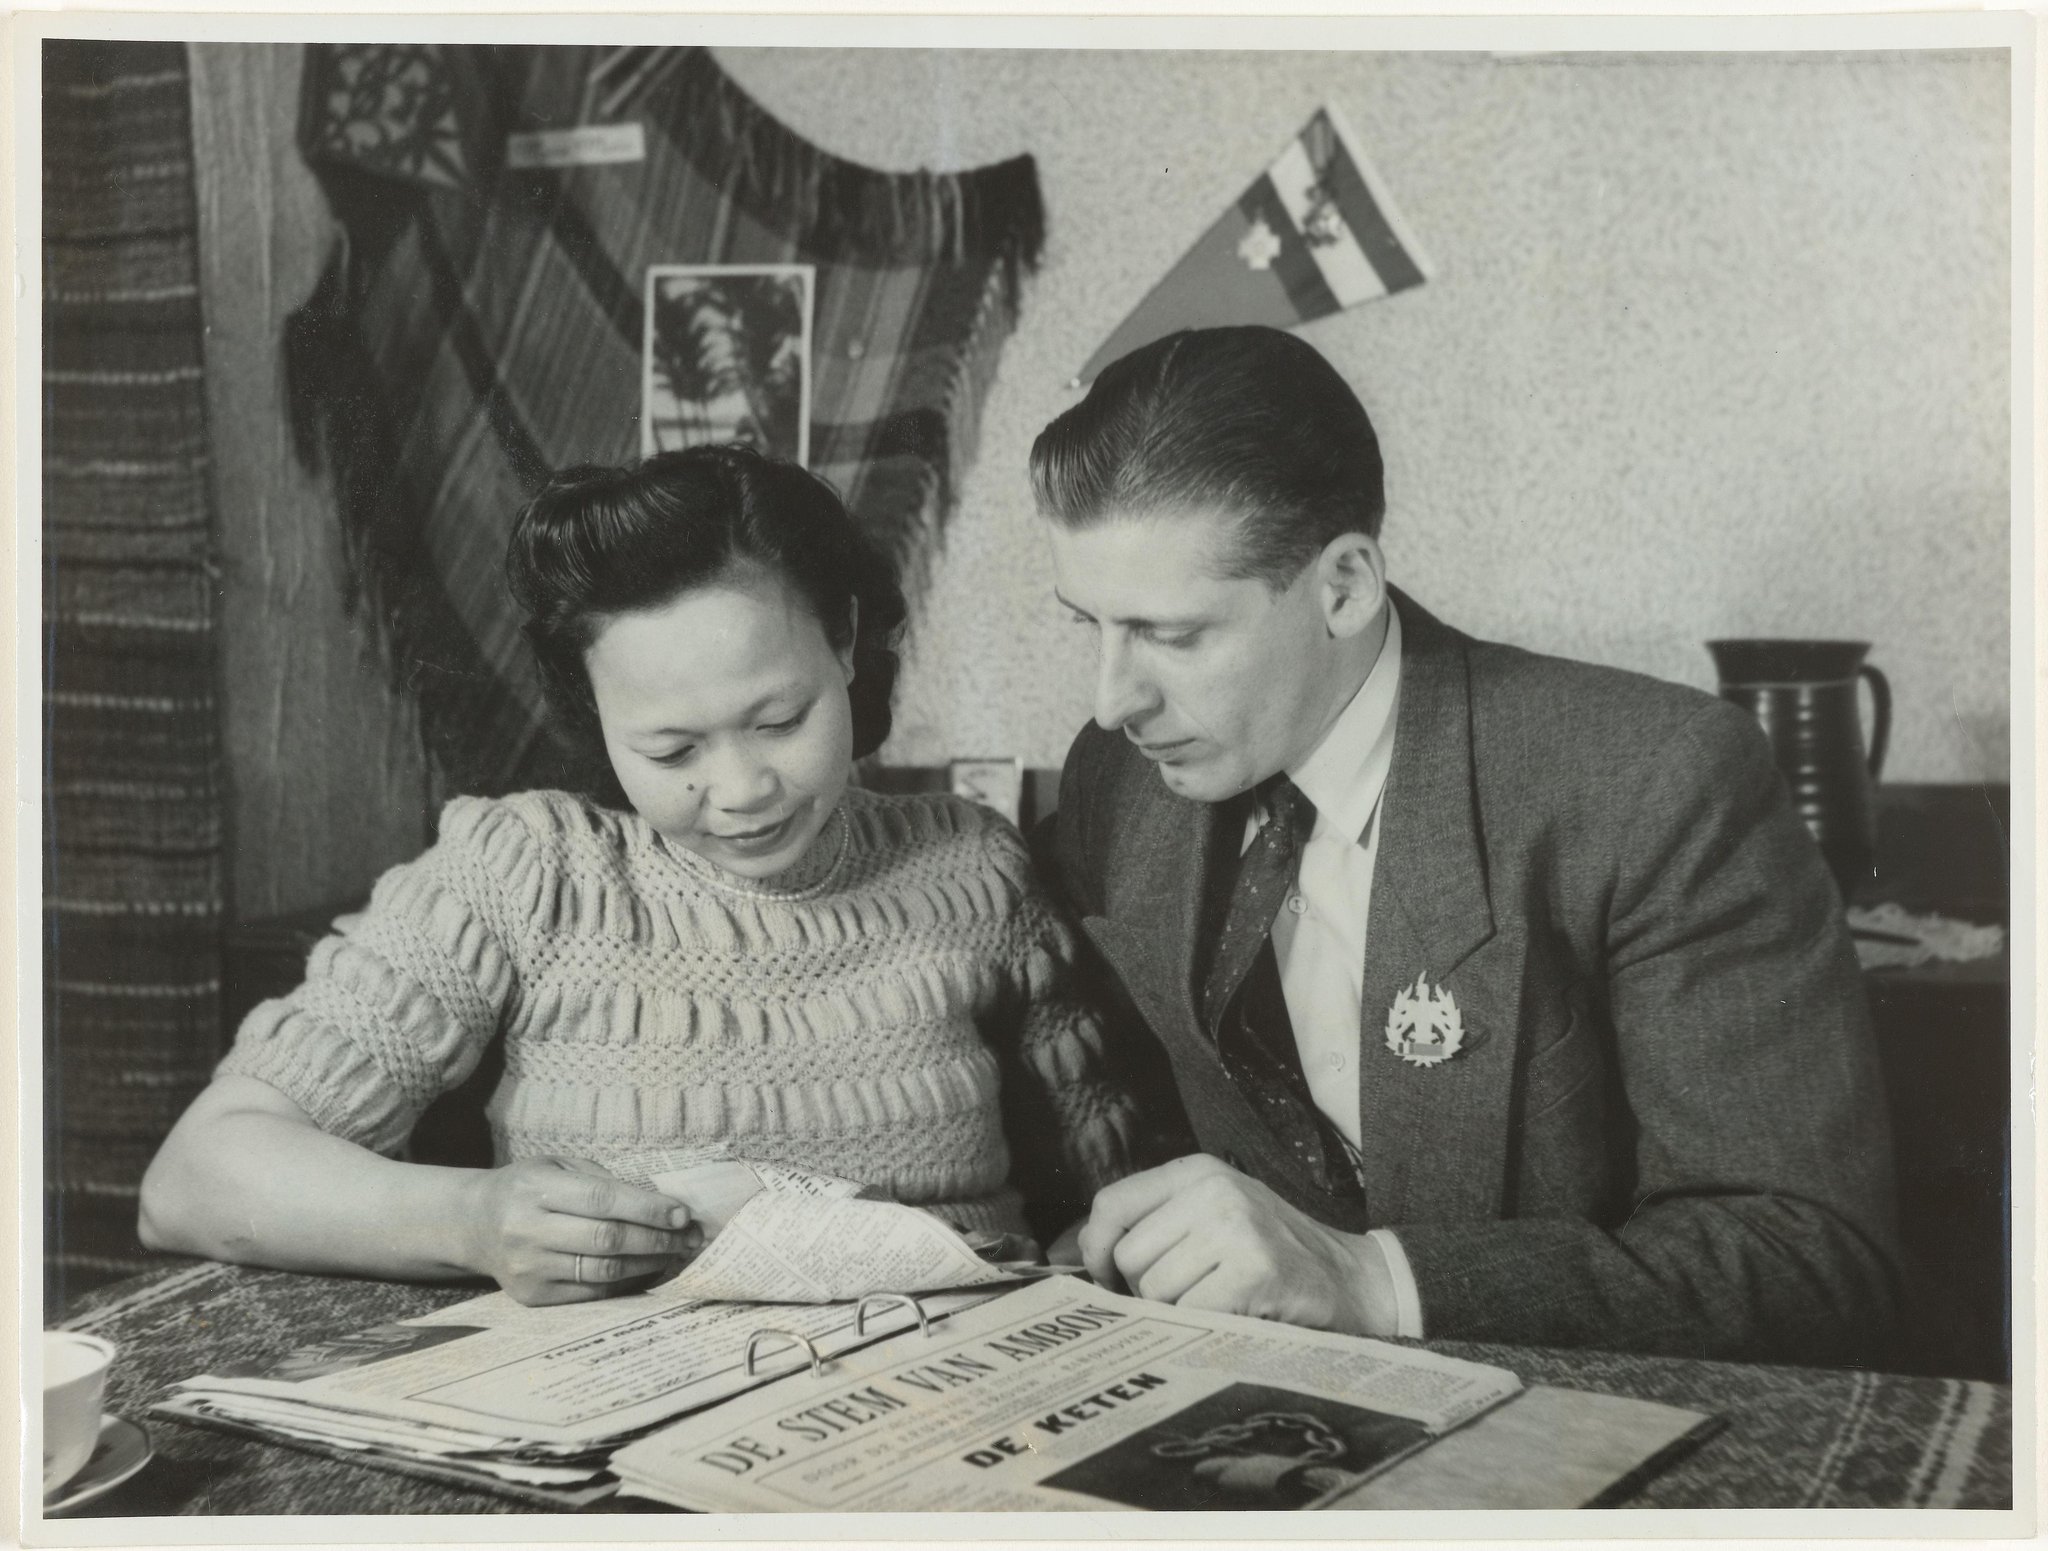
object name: photograph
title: Nederlands-Ambonees echtpaar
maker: e. de vries (fotograaf)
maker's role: fotograaf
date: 1951-1955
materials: photographic support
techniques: photography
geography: netherlands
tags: netherlands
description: Een Nederlandse man en zijn Ambonese vrouw zitten aan een tafel en bekijkt een map met kranten.